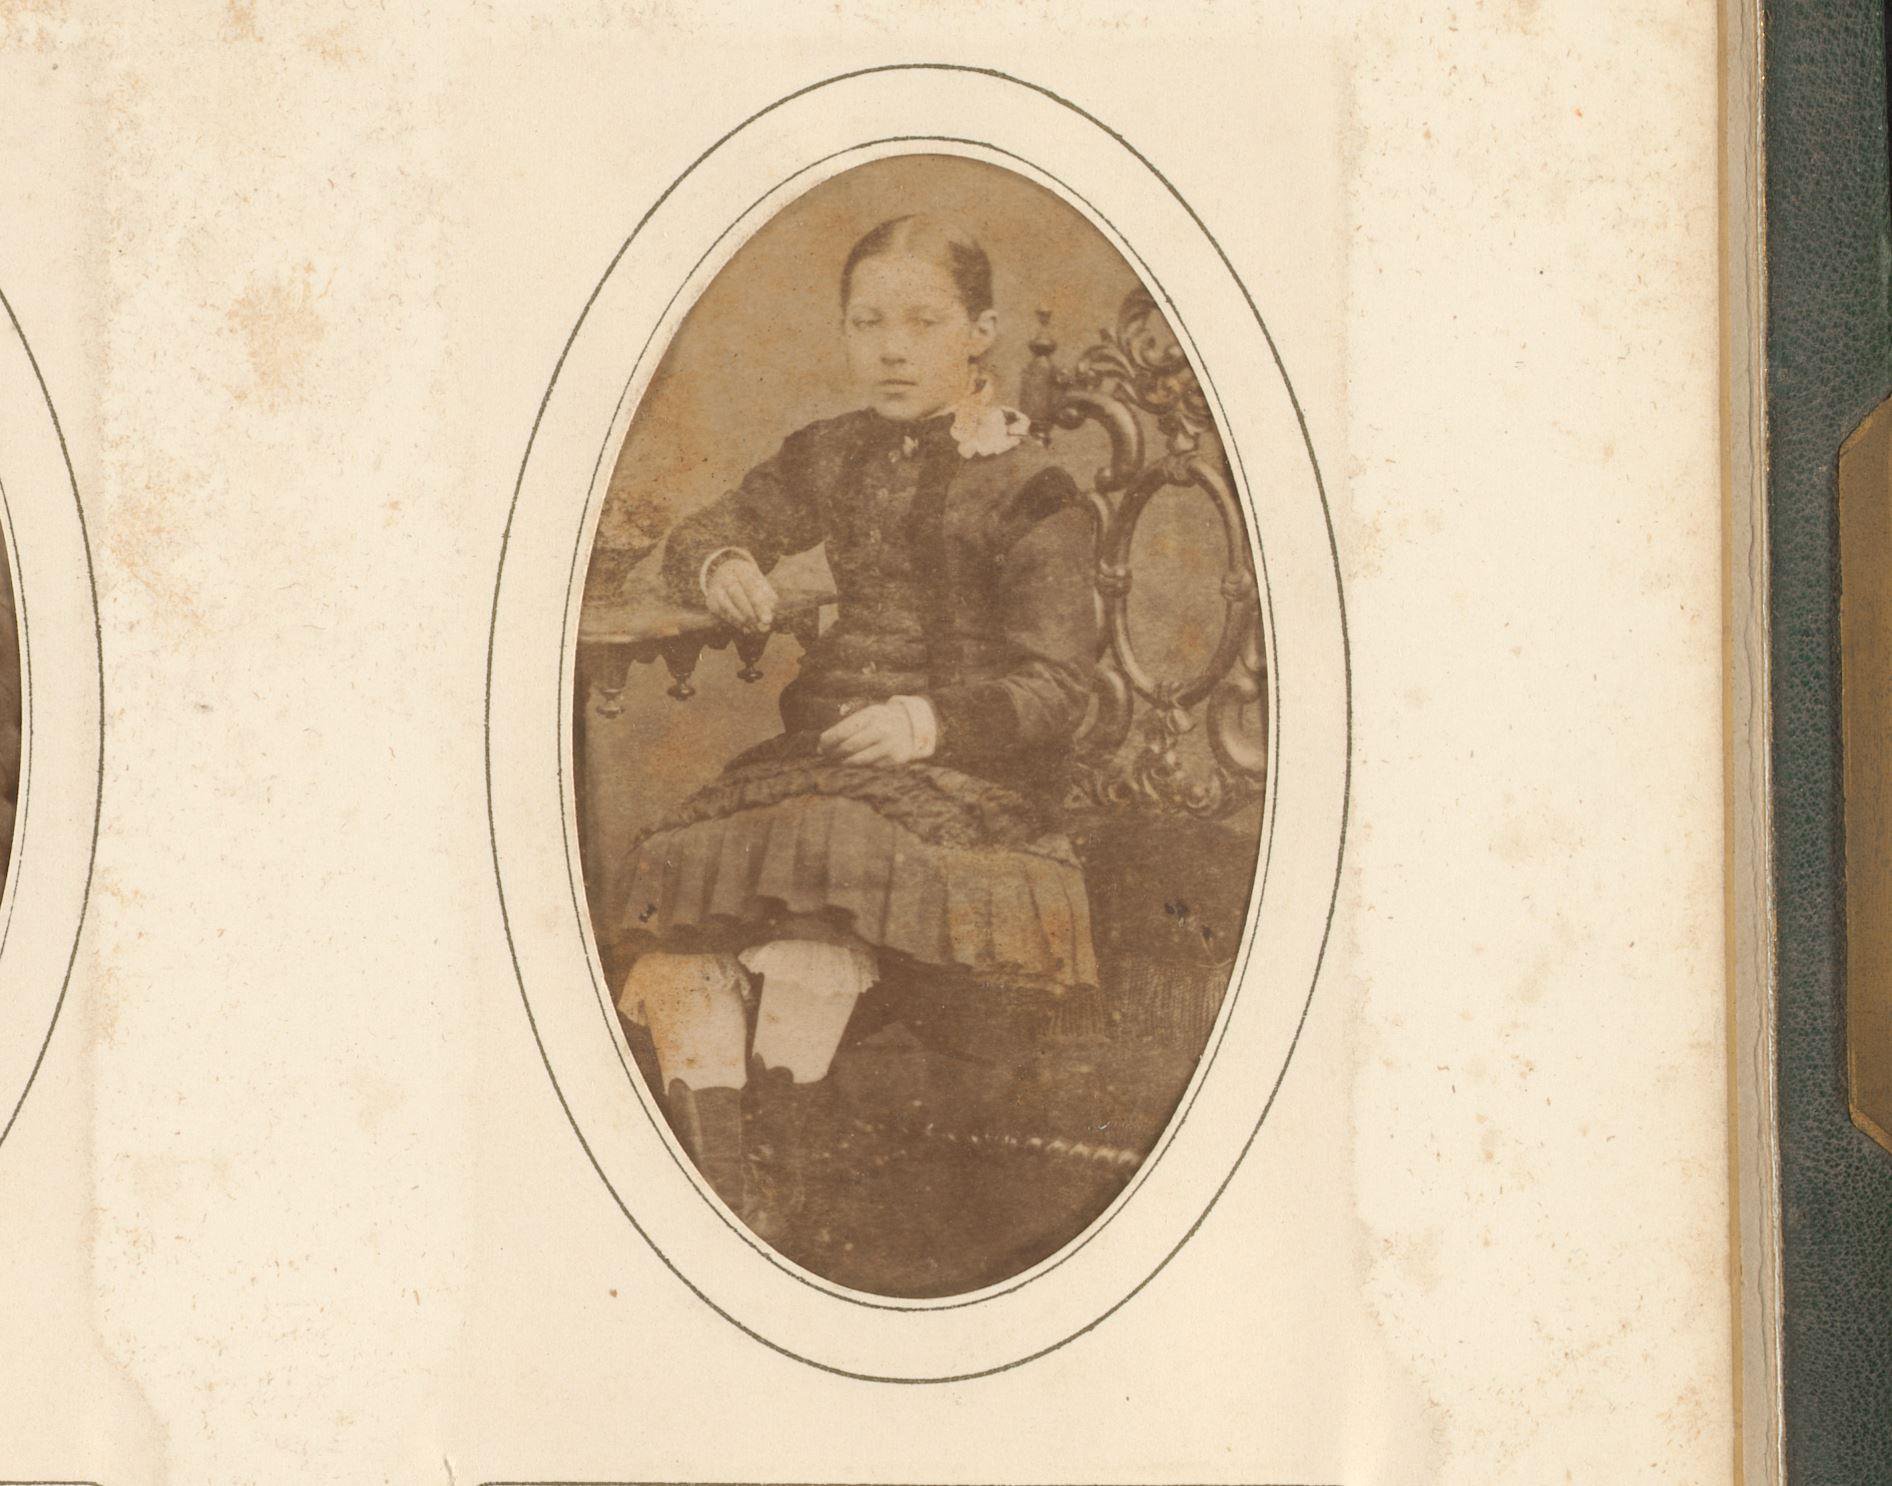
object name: album leaf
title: Portret van een zittend meisje, aangeduid als Grietje Welt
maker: johannes hermannus holman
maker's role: fotograaf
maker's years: 1833-1919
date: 1875-1899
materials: cardboard, photographic support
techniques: albumen print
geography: groningen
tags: sitting figure - aa - female human figure, historical persons - bb - woman, girl (child between toddler and youth)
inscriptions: inscription: ‘J. H. Holman/ Photographisch Atelier/ te/ GRONINGEN/ BUITEN DE HEEREPOORT/ HET CLICHÉ BLIJFT VOOR NABESTELLING BEWAARD./ SPECIALE INRIGTING VOOR VERGROOTINGEN EN COPIEN.’, name: ‘Grietje Wel[t]’